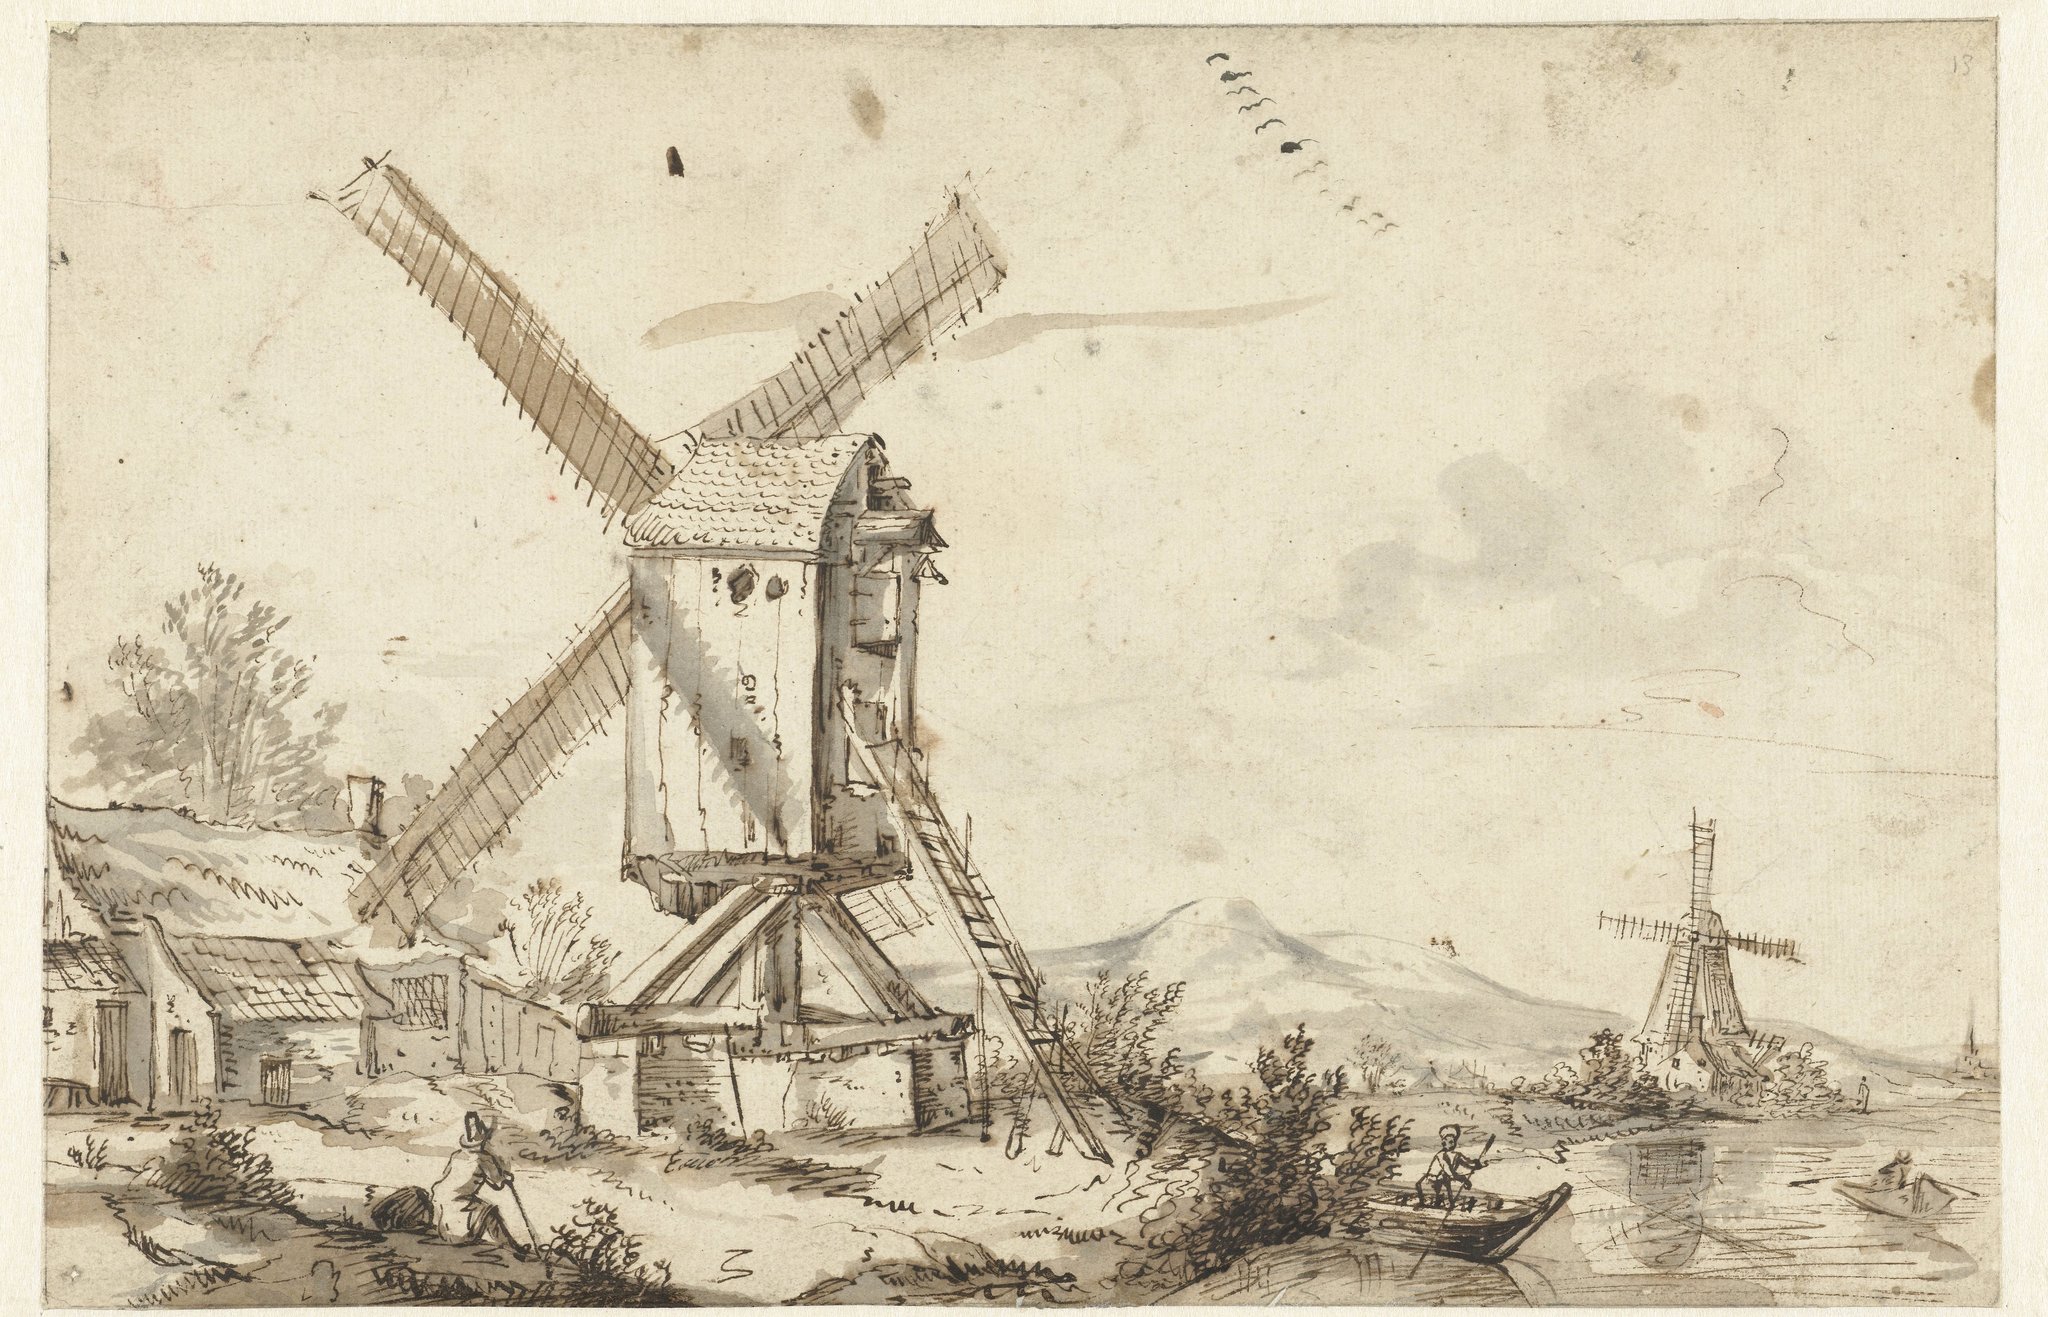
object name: drawing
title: Landschap met twee windmolens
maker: Anonymous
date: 1600-1699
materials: ink, paper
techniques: brush, pen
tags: windmill in landscape, windmill